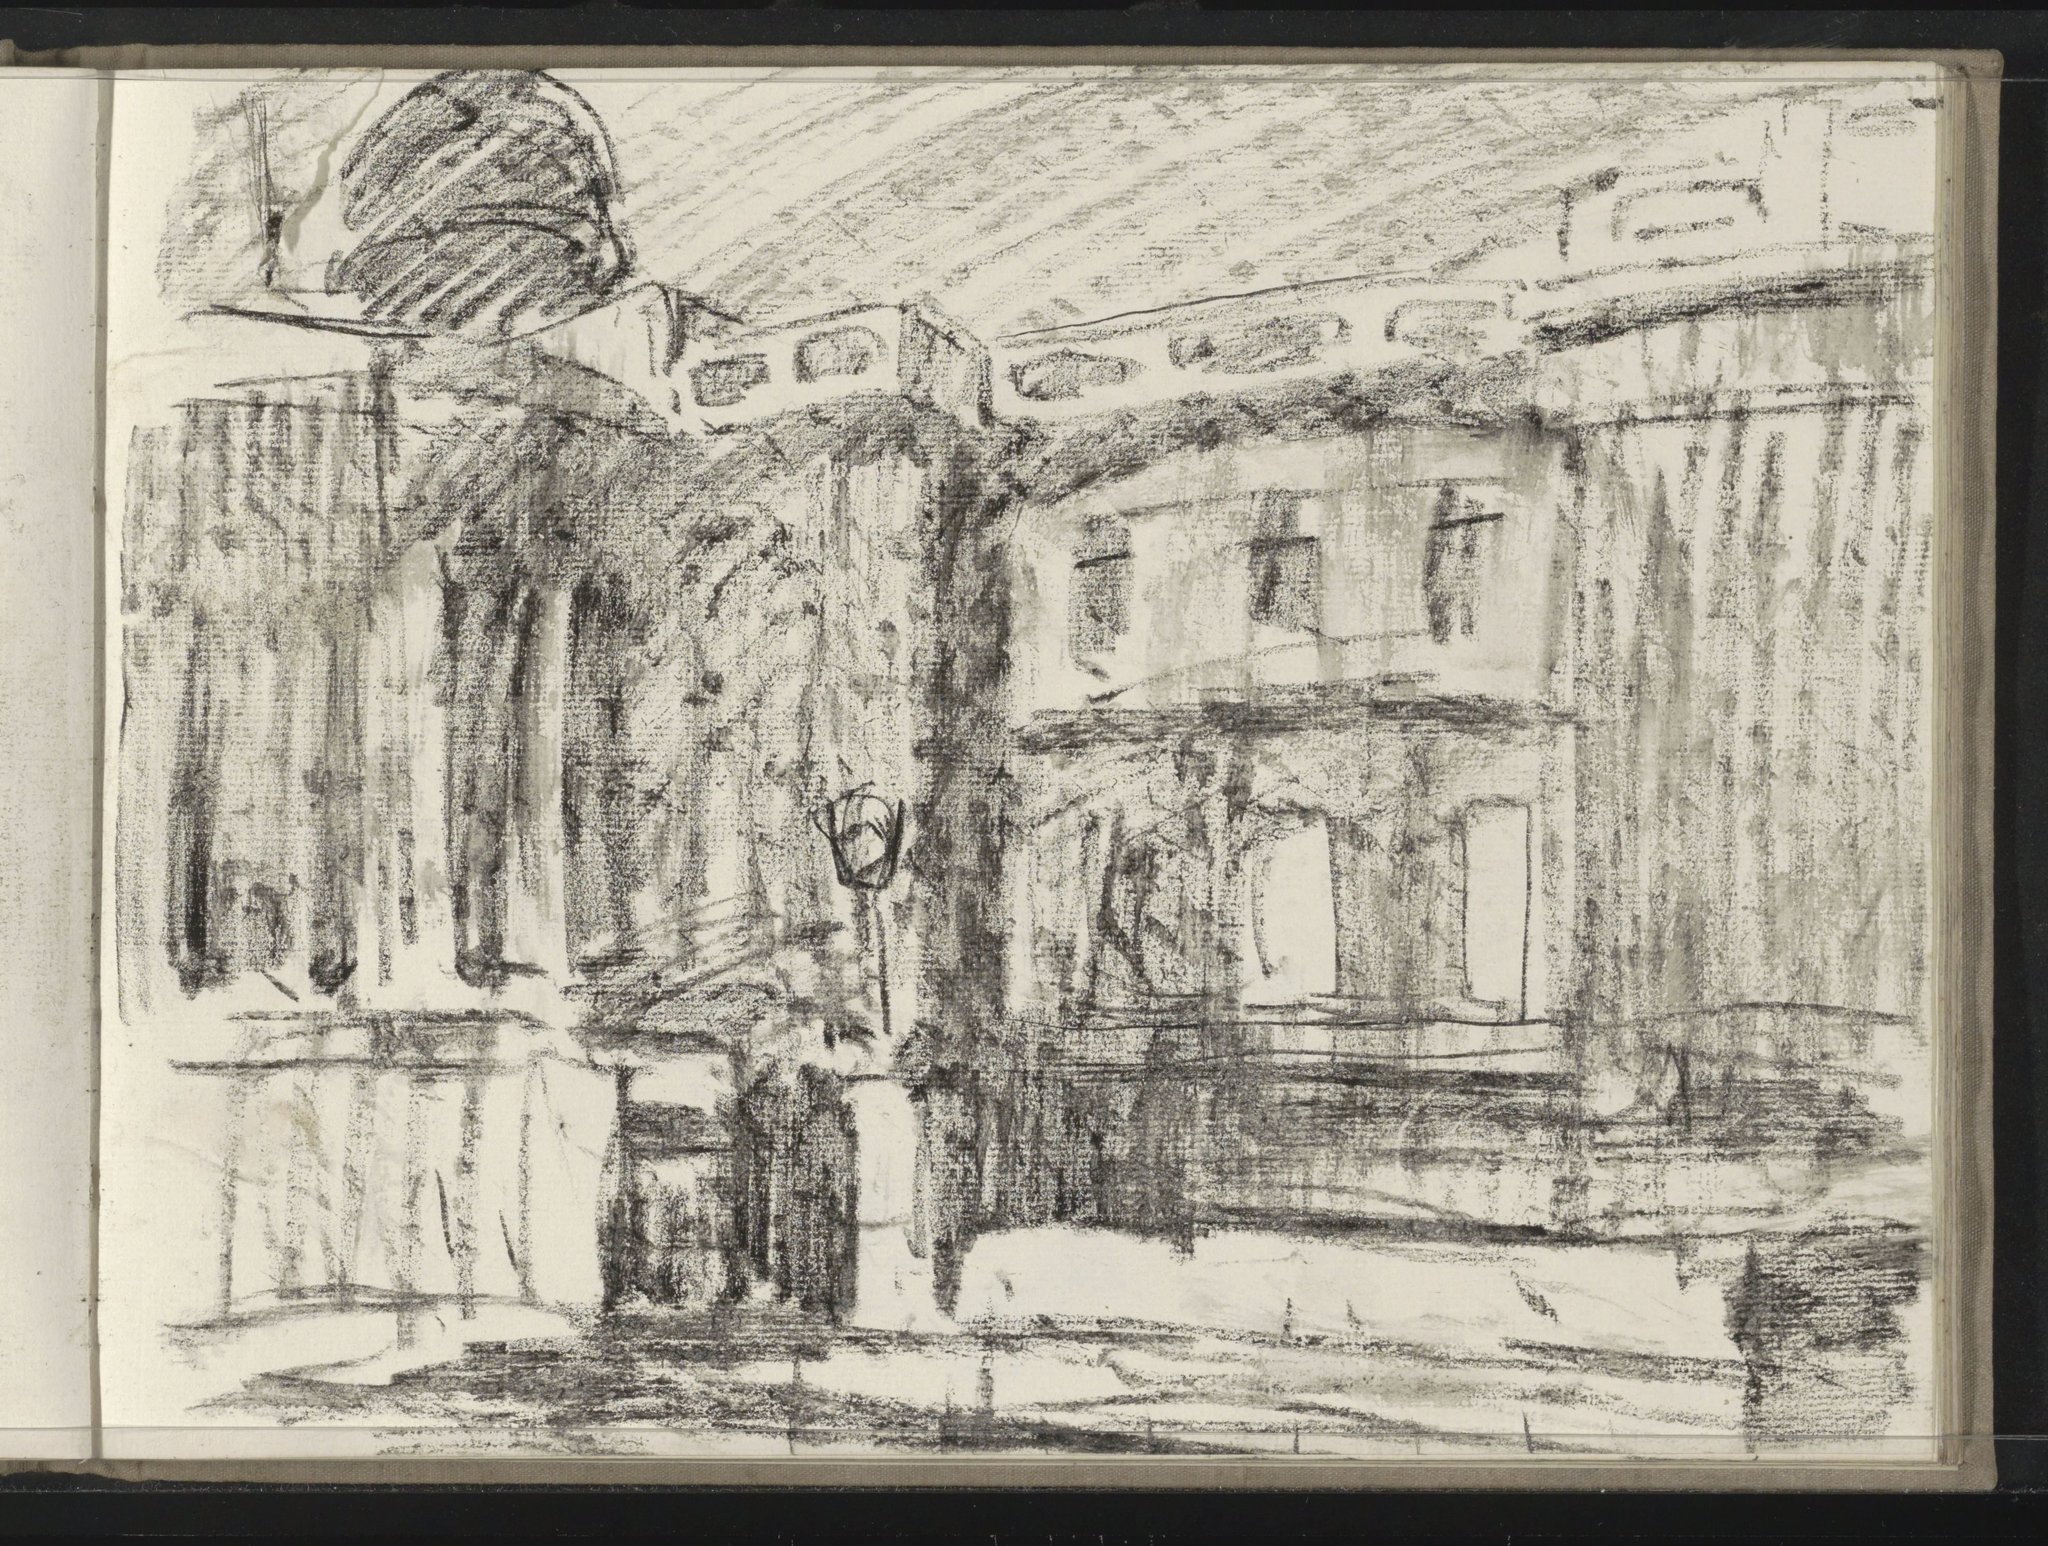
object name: sketchbook leaf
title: Gezicht op de National Gallery te Londen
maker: willem witsen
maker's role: draughtsman, painter, print maker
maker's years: 1860-1923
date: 1888-1891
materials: chalk, paper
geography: london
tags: edifice, e.g.: public building, department store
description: Voorstudie voor de ets 'Avond bij de National Gallery, Londen', ca. 1890.